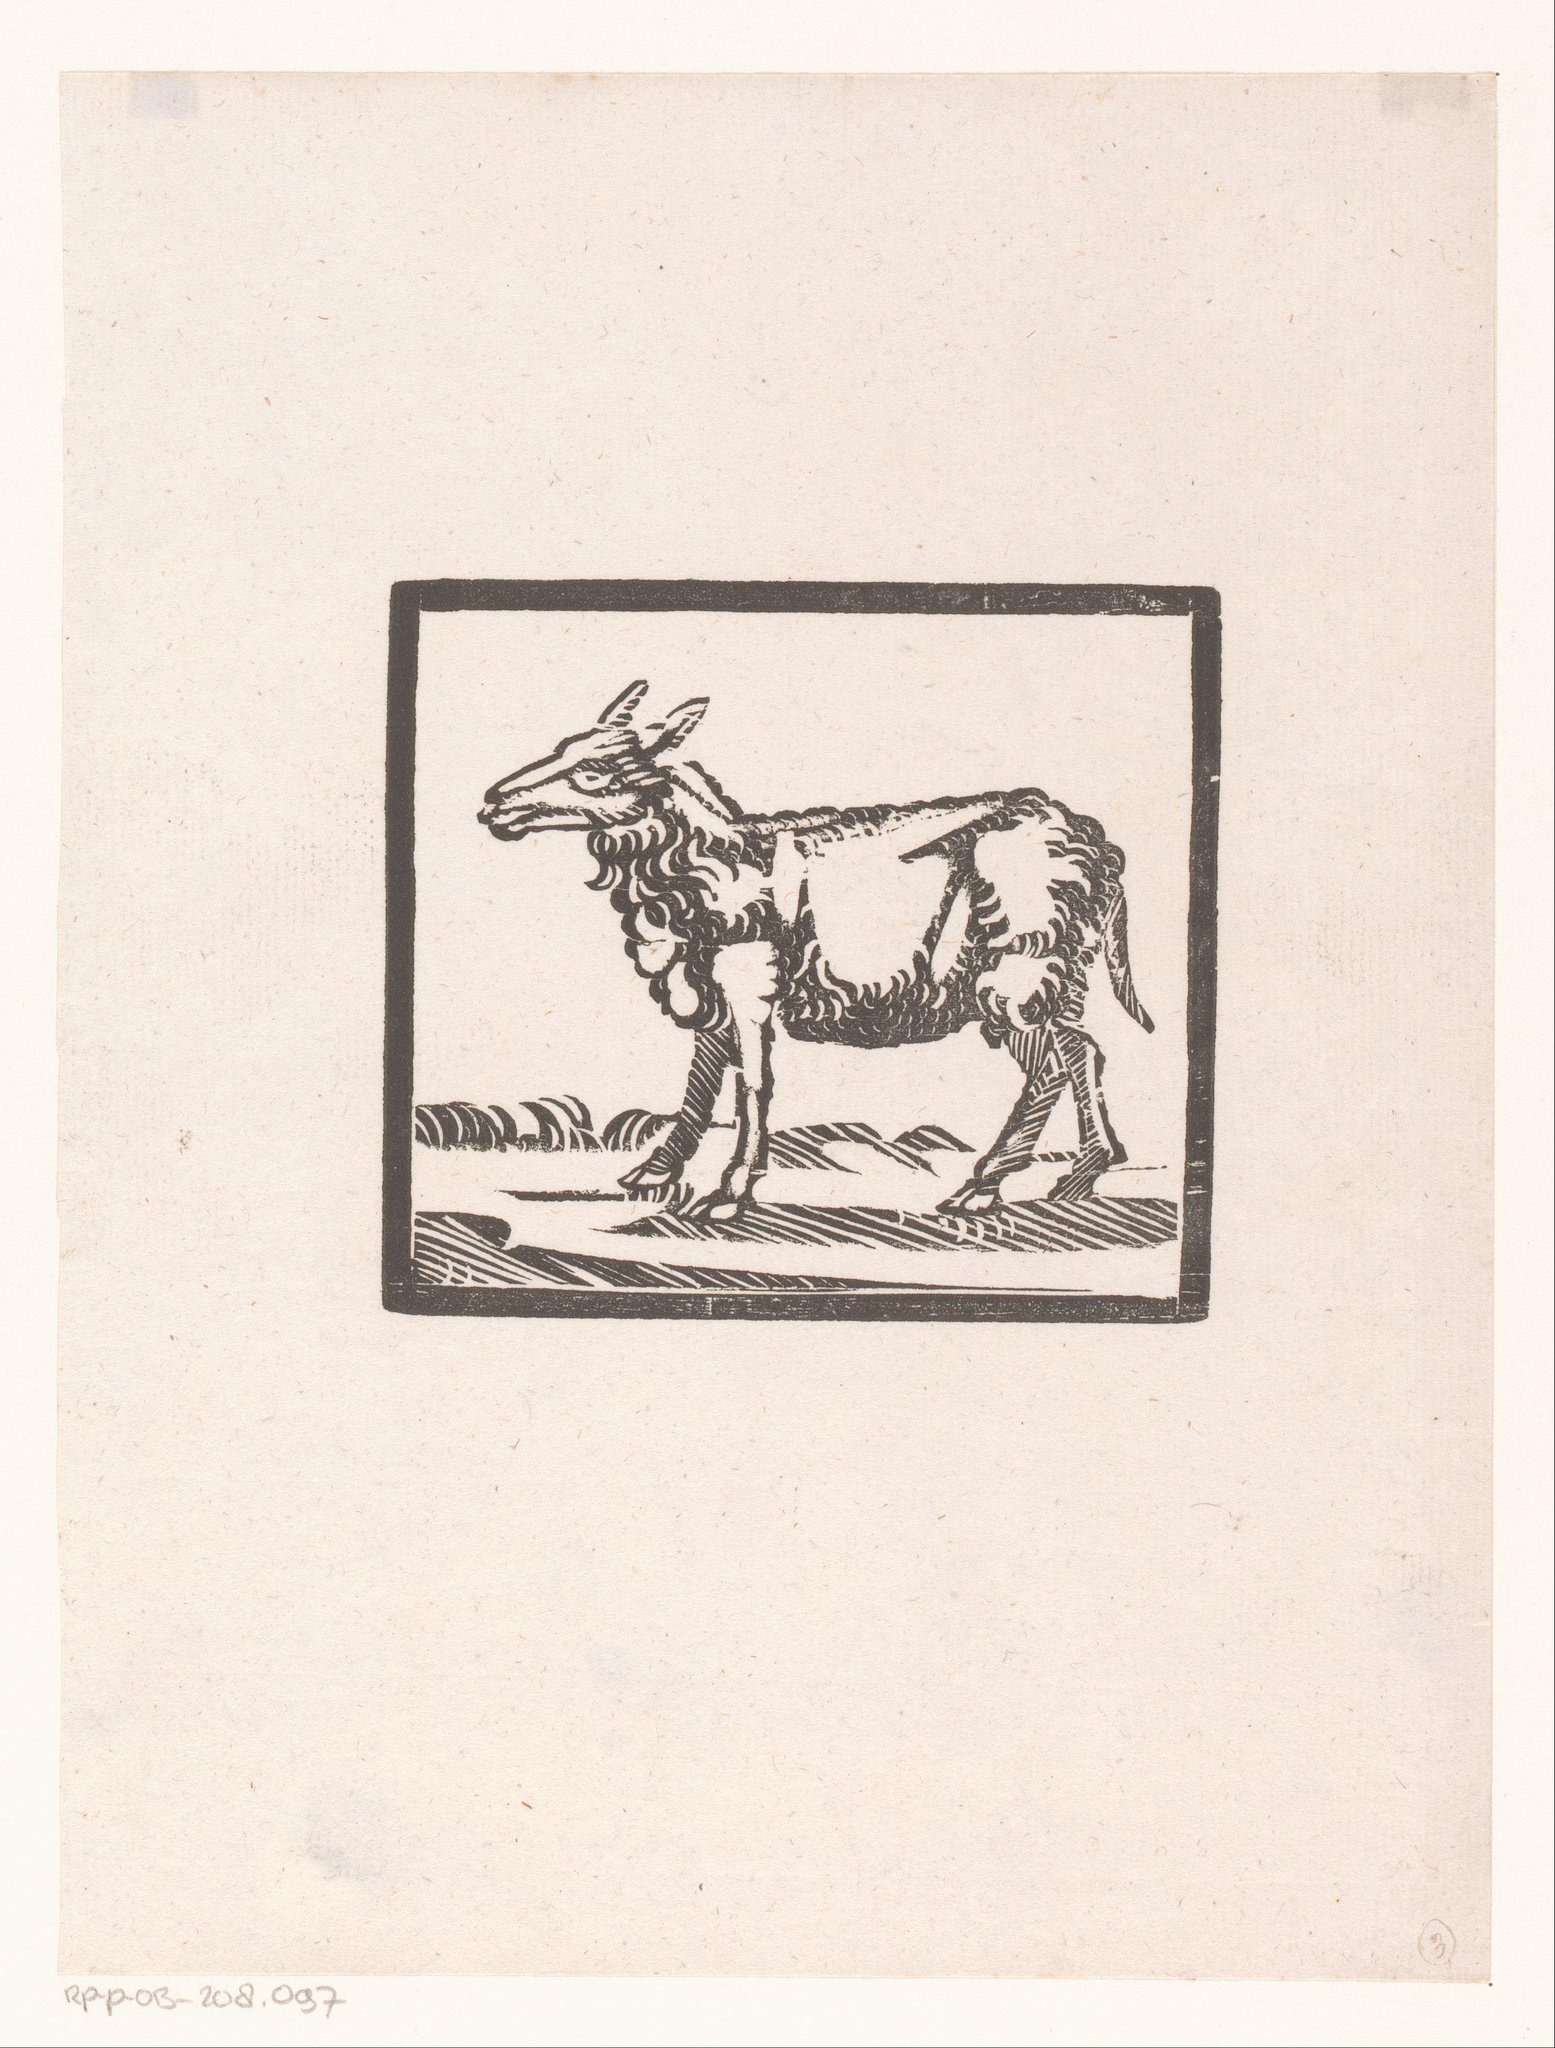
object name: print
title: Schaap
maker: Anonymous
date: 1600-1699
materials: paper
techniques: woodcut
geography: netherlands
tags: sheep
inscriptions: collector's mark: Lugt 2228